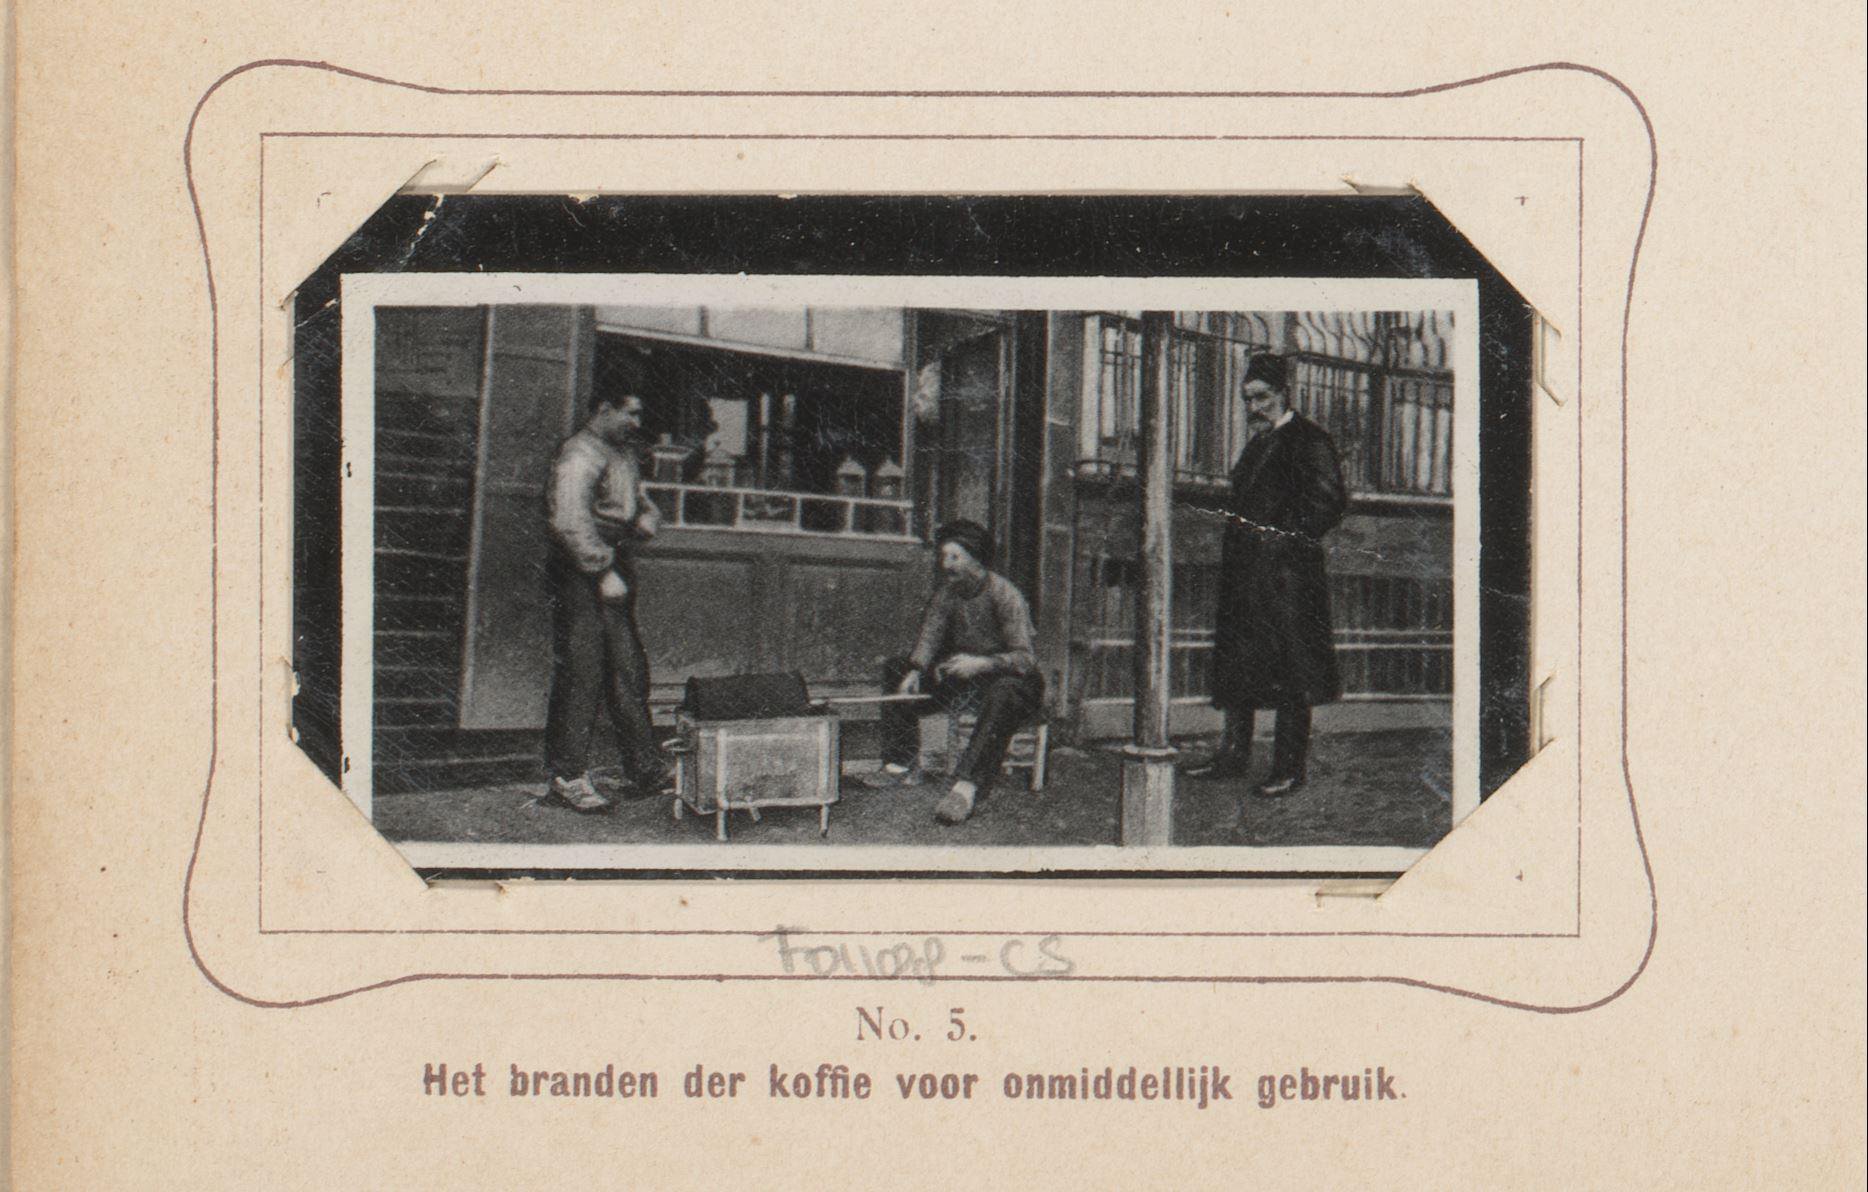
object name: album leaf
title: Man brandt koffie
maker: Anonymous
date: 1906-1907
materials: paper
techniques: photograph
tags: coffee, roasting, grilling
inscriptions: inscription: ‘No. 5./ Het branden der koffie voor onmiddelijk gebruik.’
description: Deze prent maakt deel uit van een album.